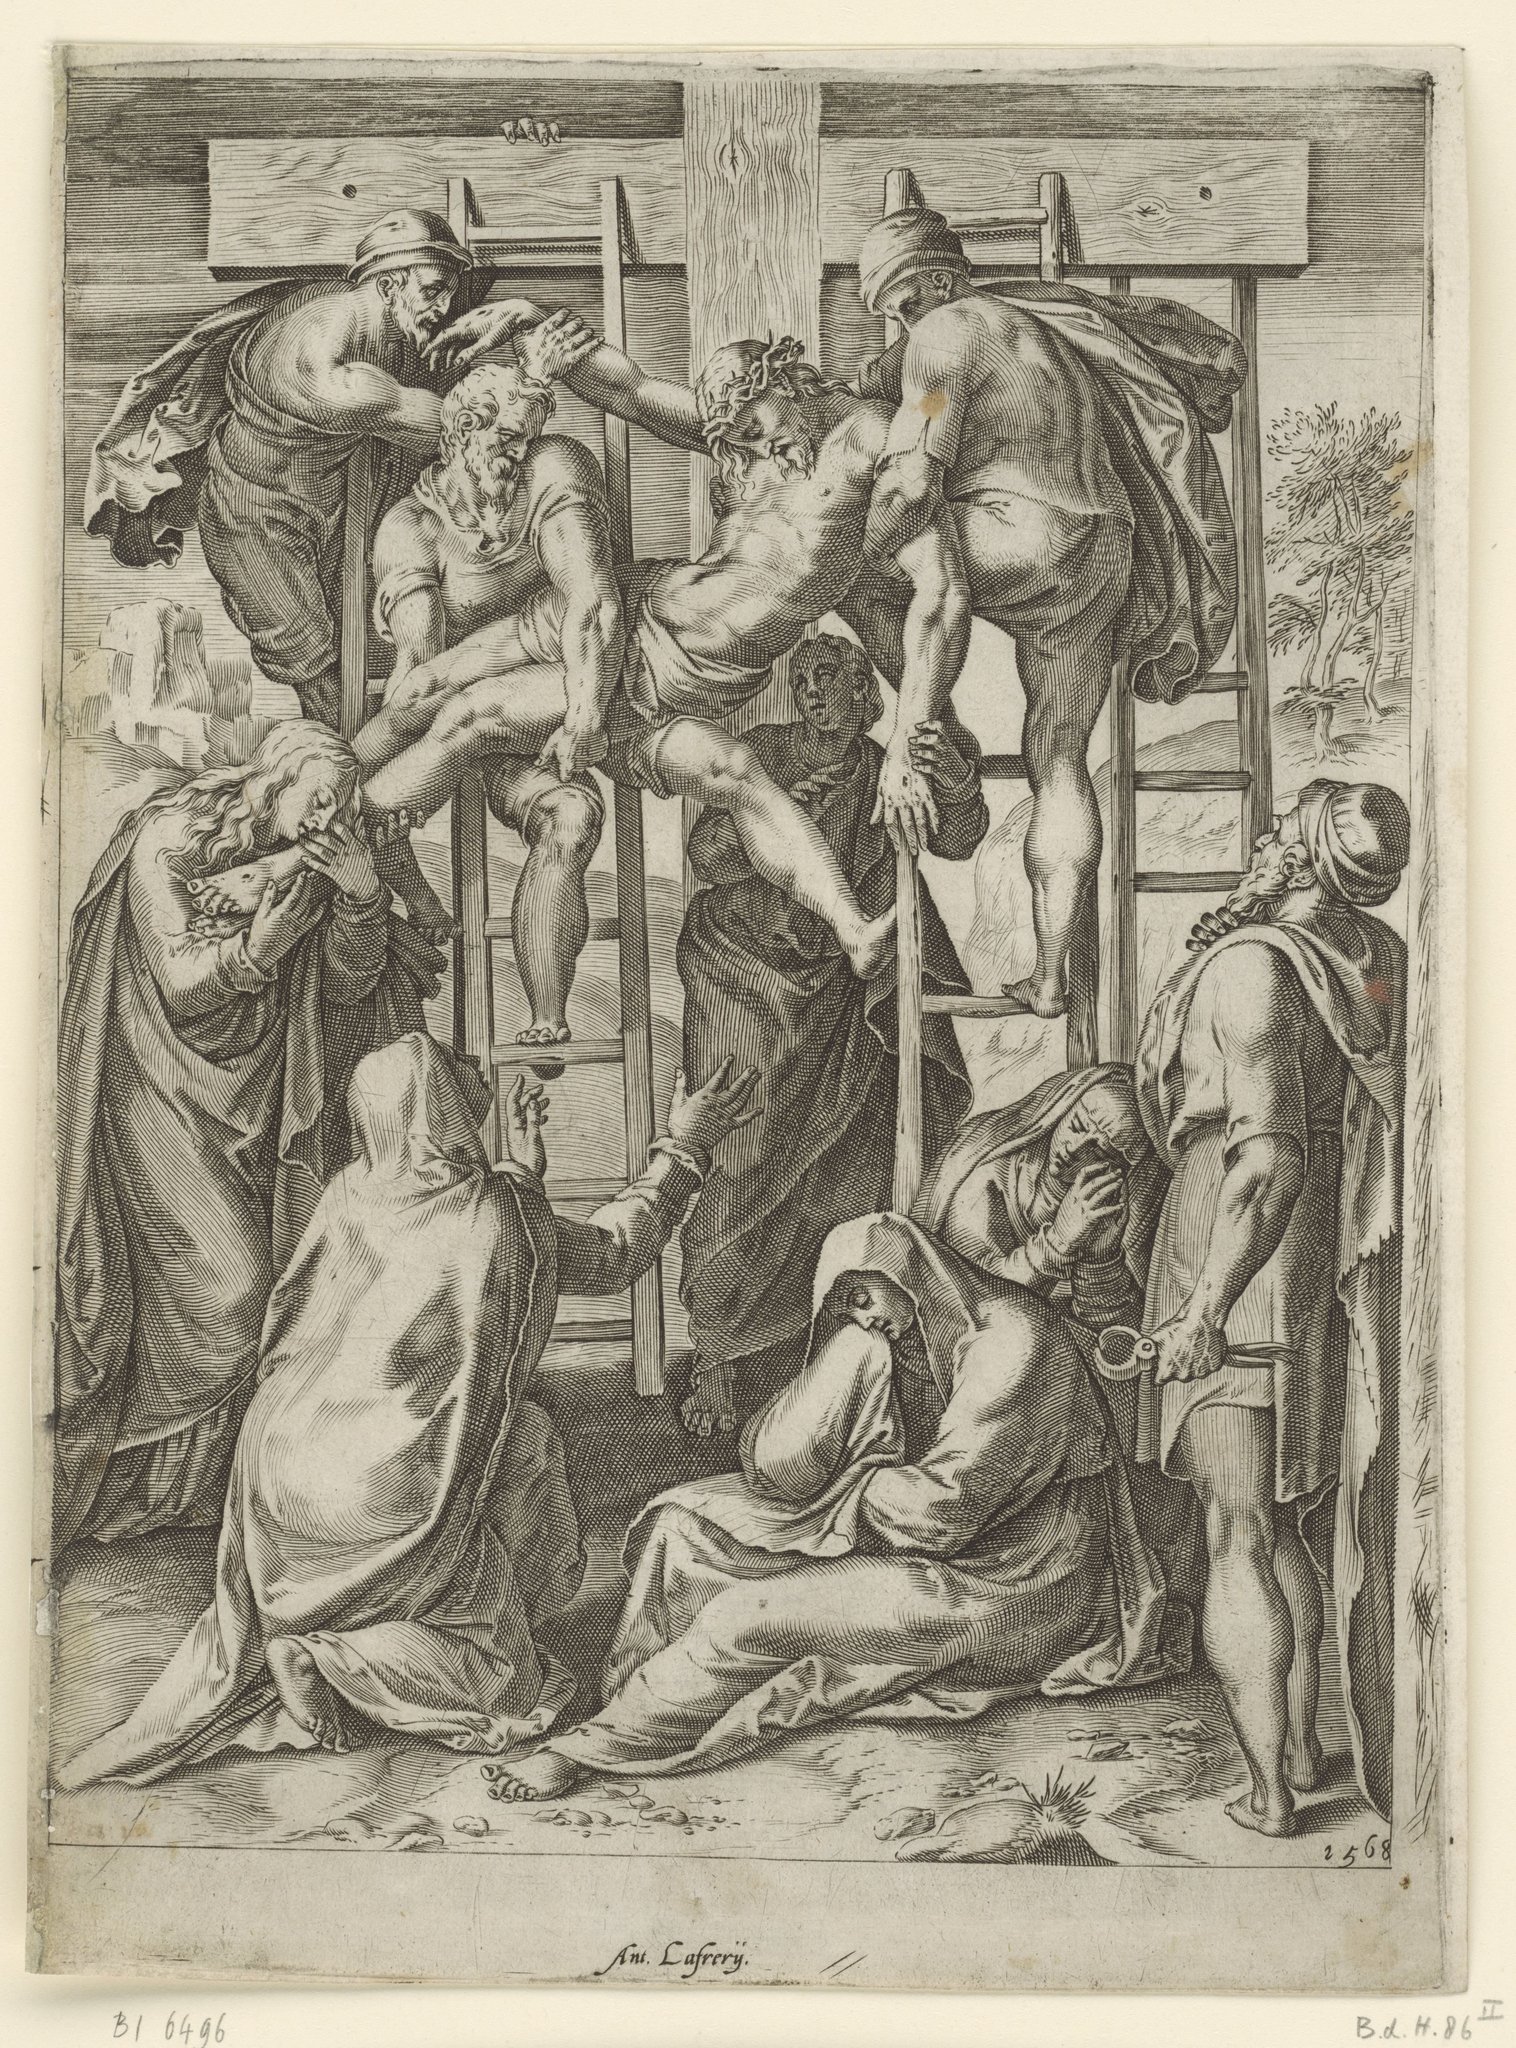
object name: print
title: Kruisafneming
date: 1568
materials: paper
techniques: engraving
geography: rome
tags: descent from the cross: christ is taken down from the cross, usually by nicodemus and joseph of arimathaea who are standing on the ladders (both arms of christ detached)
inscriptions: address: ‘Ant. Lafrerij.’, date: ‘1568’, collector's mark: Lugt 2228, collector's mark: Lugt 1789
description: Christus wordt van het kruis gehaald door Nicodemus en Jozef van Arimathea. Er staan vier ladders tegen het kruis. Maria Magdalena grijpt naar Christus voeten. Op de grond zitten wenende vrouwen.